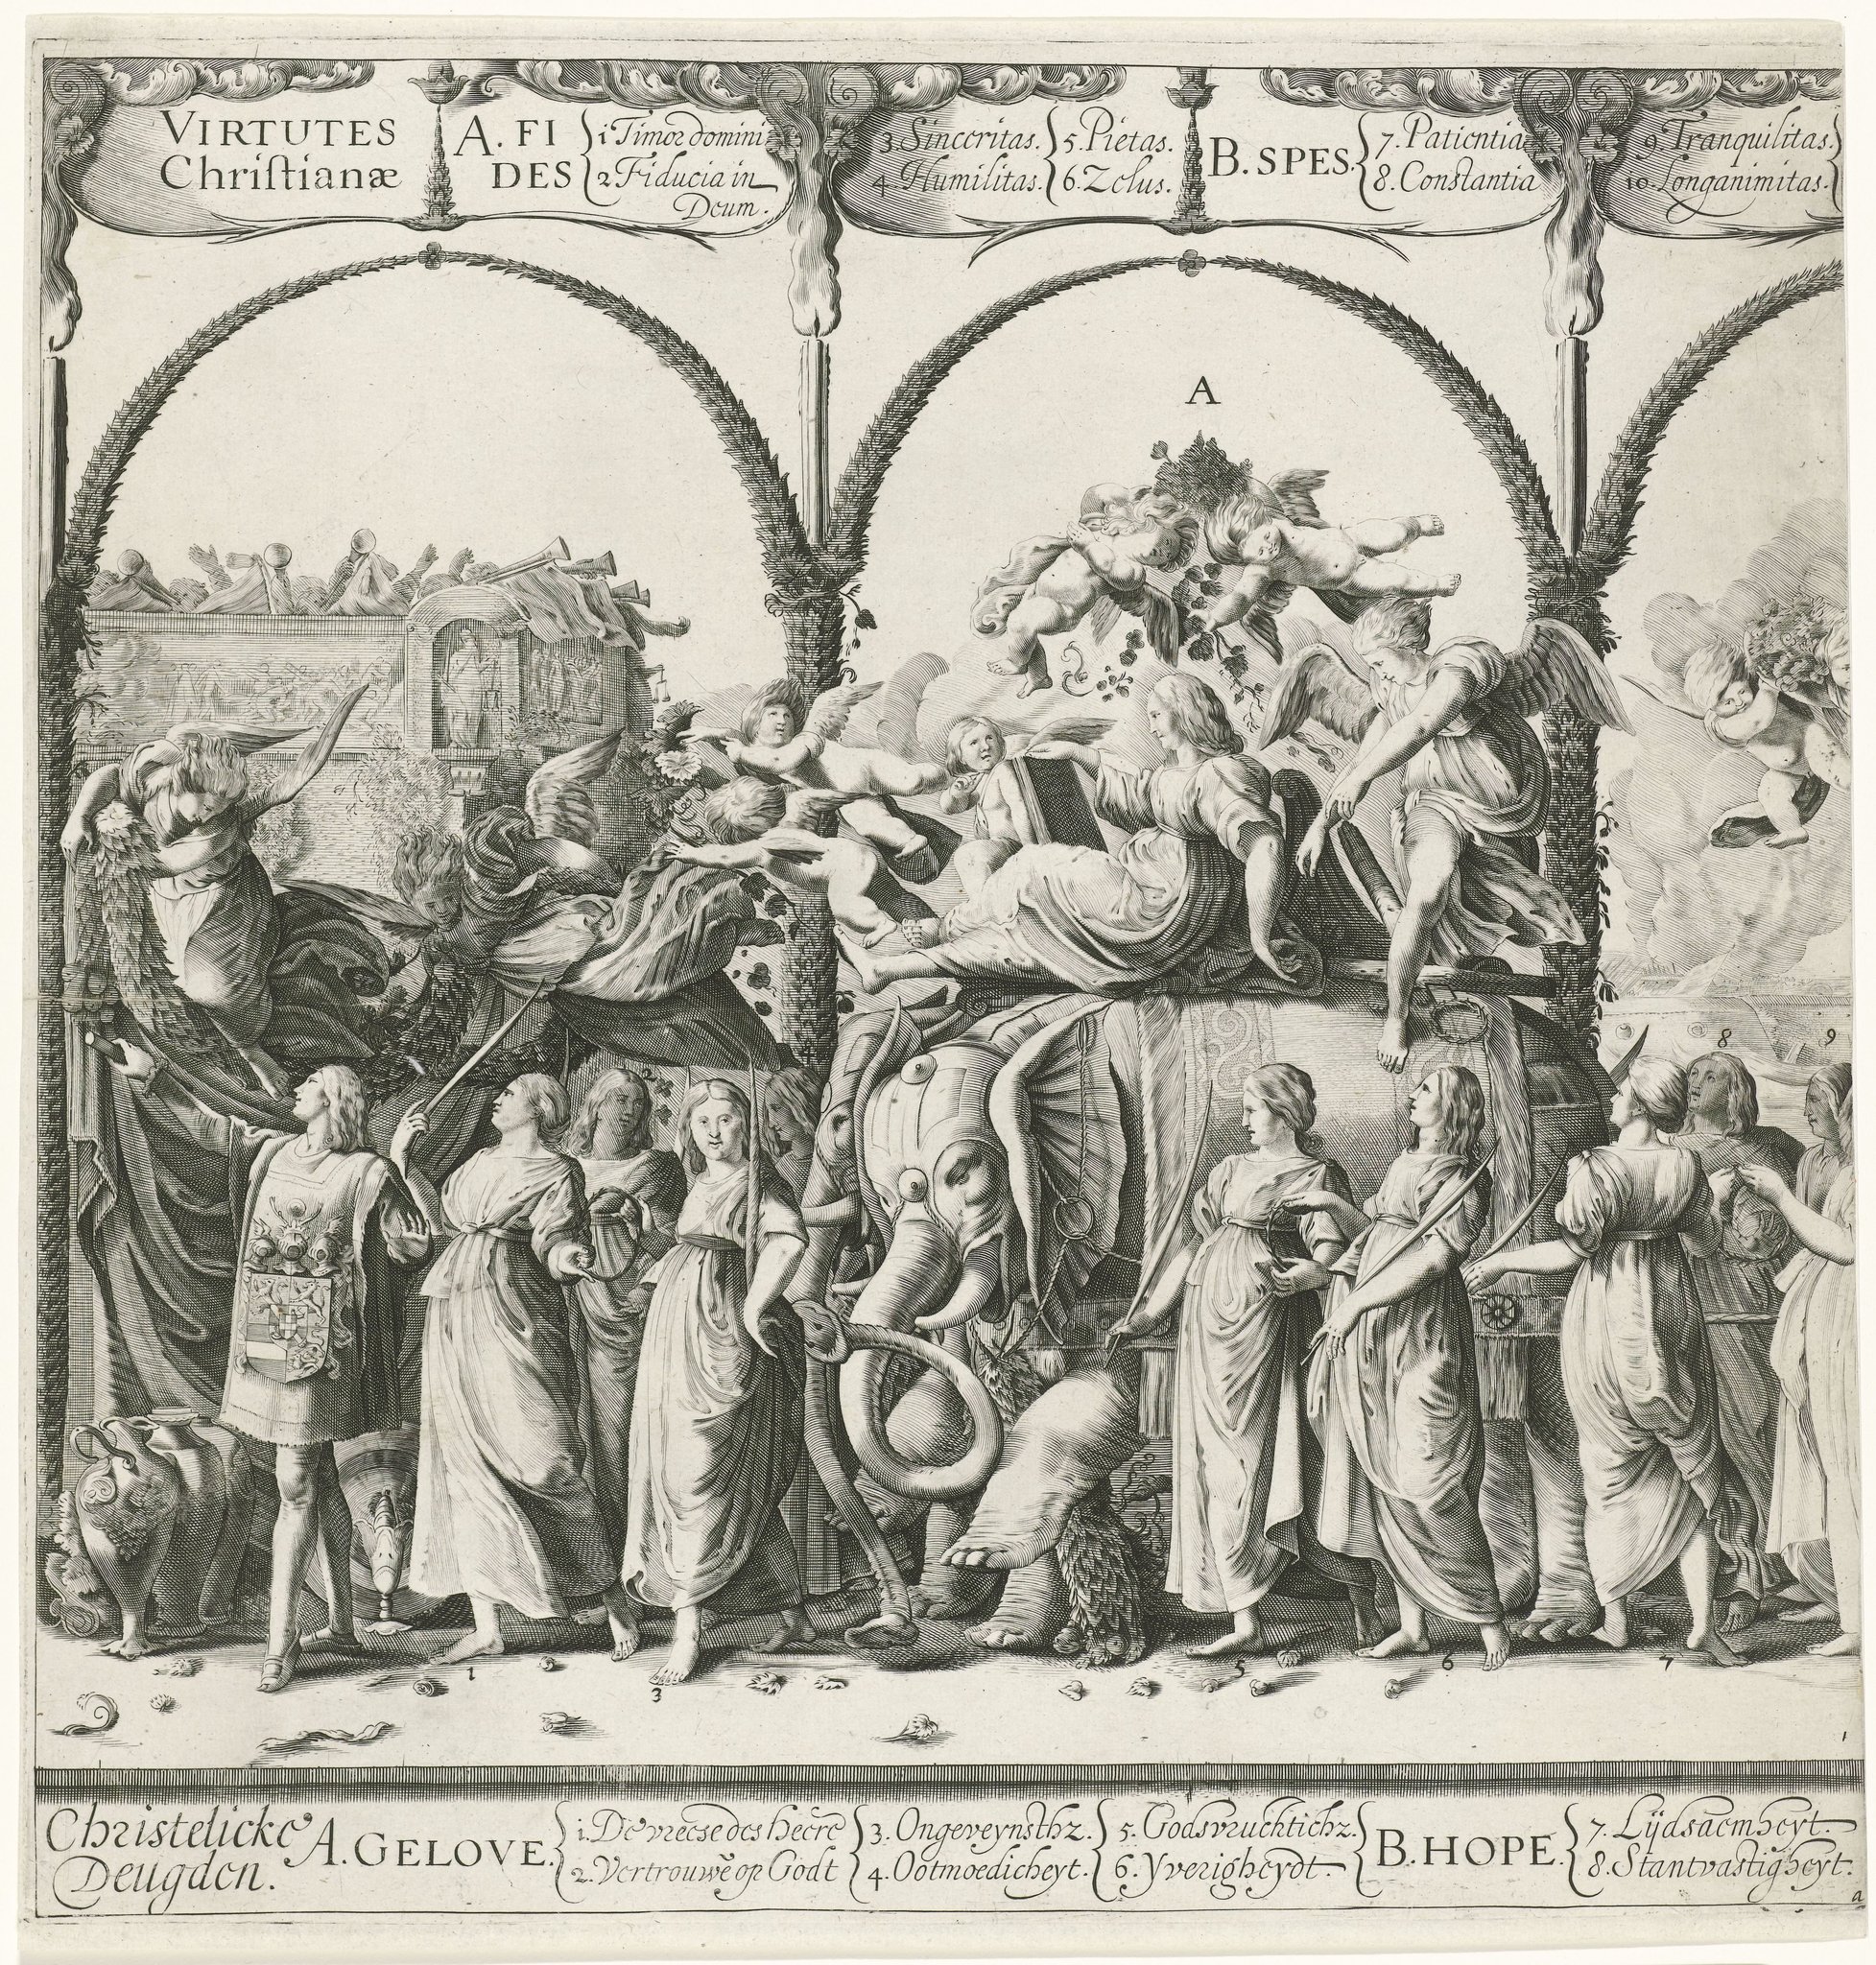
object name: propagandaprent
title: Currus triumphalis Illustris / Triomftocht van Willem van Oranje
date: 1623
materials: paper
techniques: engraving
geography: haarlem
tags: delft, william i (prince of orange), faith, 'fides'; 'fede', 'fede catholica', 'fede christiana', 'fede christiana catholica' (ripa) ~ one of the three theological virtues, symbolic triumphs of individual persons, trunked animals: elephant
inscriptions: collector's mark: Lugt 240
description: Zinnebeeldige voorstelling van de deugden van Prins Willem van Oranje. Zegewagen waarin de prins zit, rijdt onder een erepoort van loofwerk door, getrokken door 3 olifanten. De olifant met de personificatie Geloof; naast haar andere personificaties van deugden. Met uitleg in het Latijn boven de figuren, Hollandse vertaling onderaan.